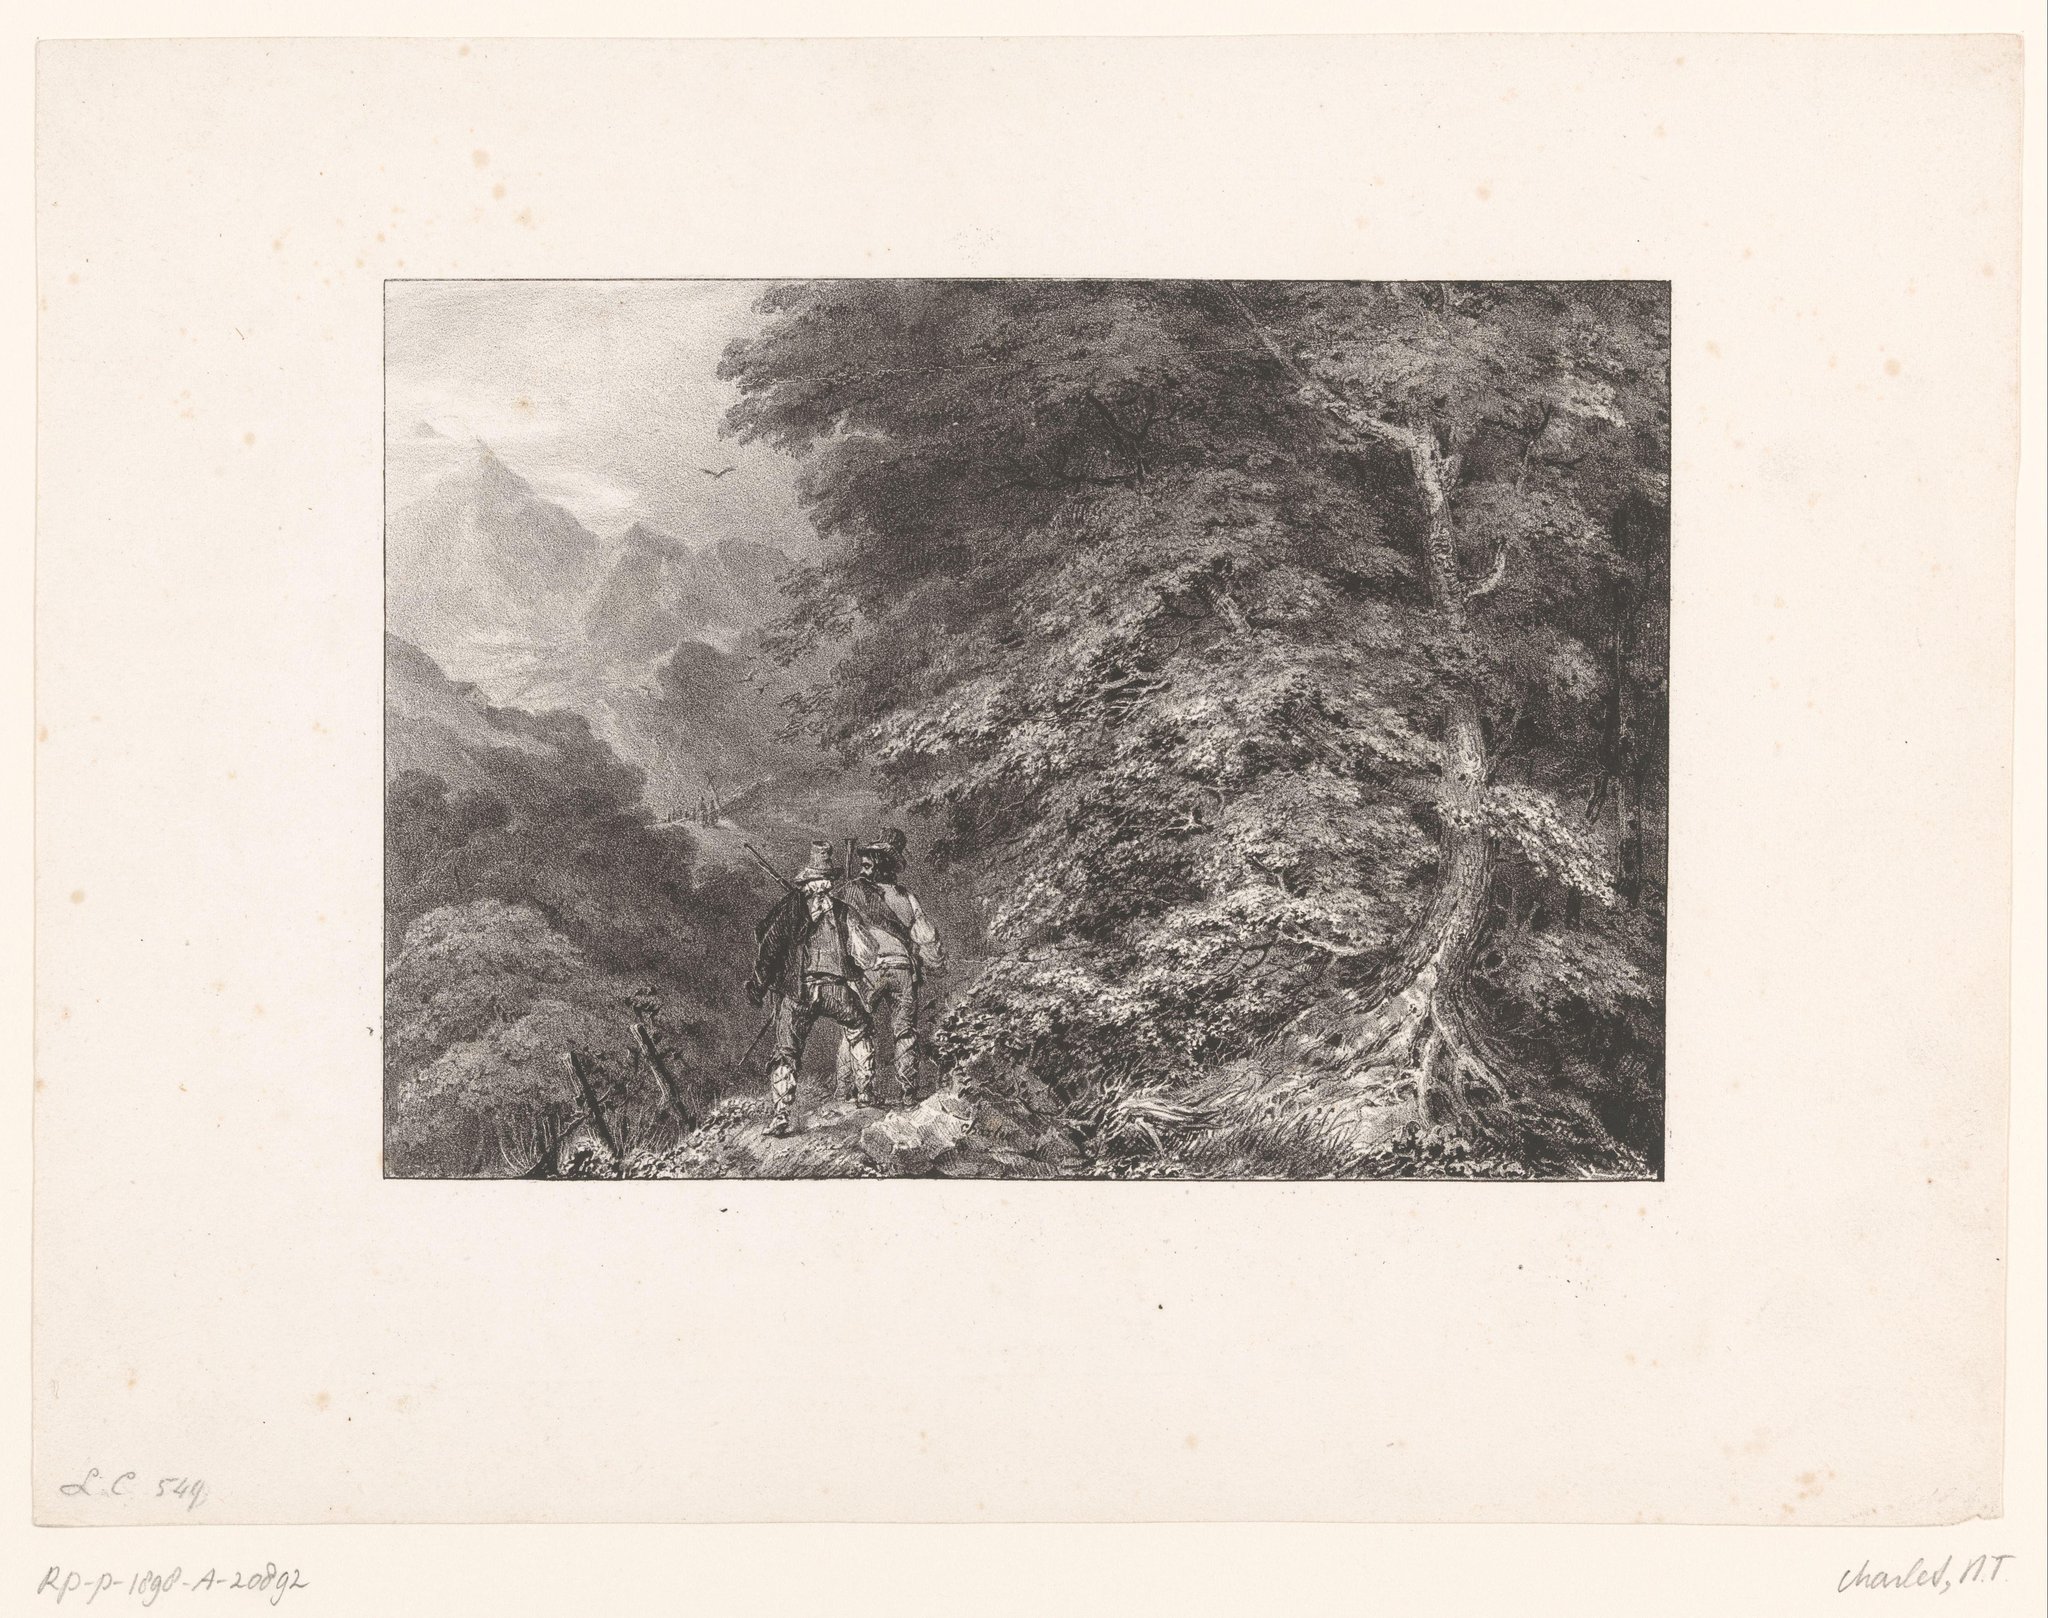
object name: print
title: Guerillas navarrois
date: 1824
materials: paper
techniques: lithograph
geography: paris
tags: guerilla warfare (+ situation of the terrain ~ warfare), surprise attack (from ambush), mountains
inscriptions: collector's mark: Lugt 2228a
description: Op de achtergrond is een groep figuren zichtbaar, die door de guerrillastrijders in een hinderlaag worden gelokt.